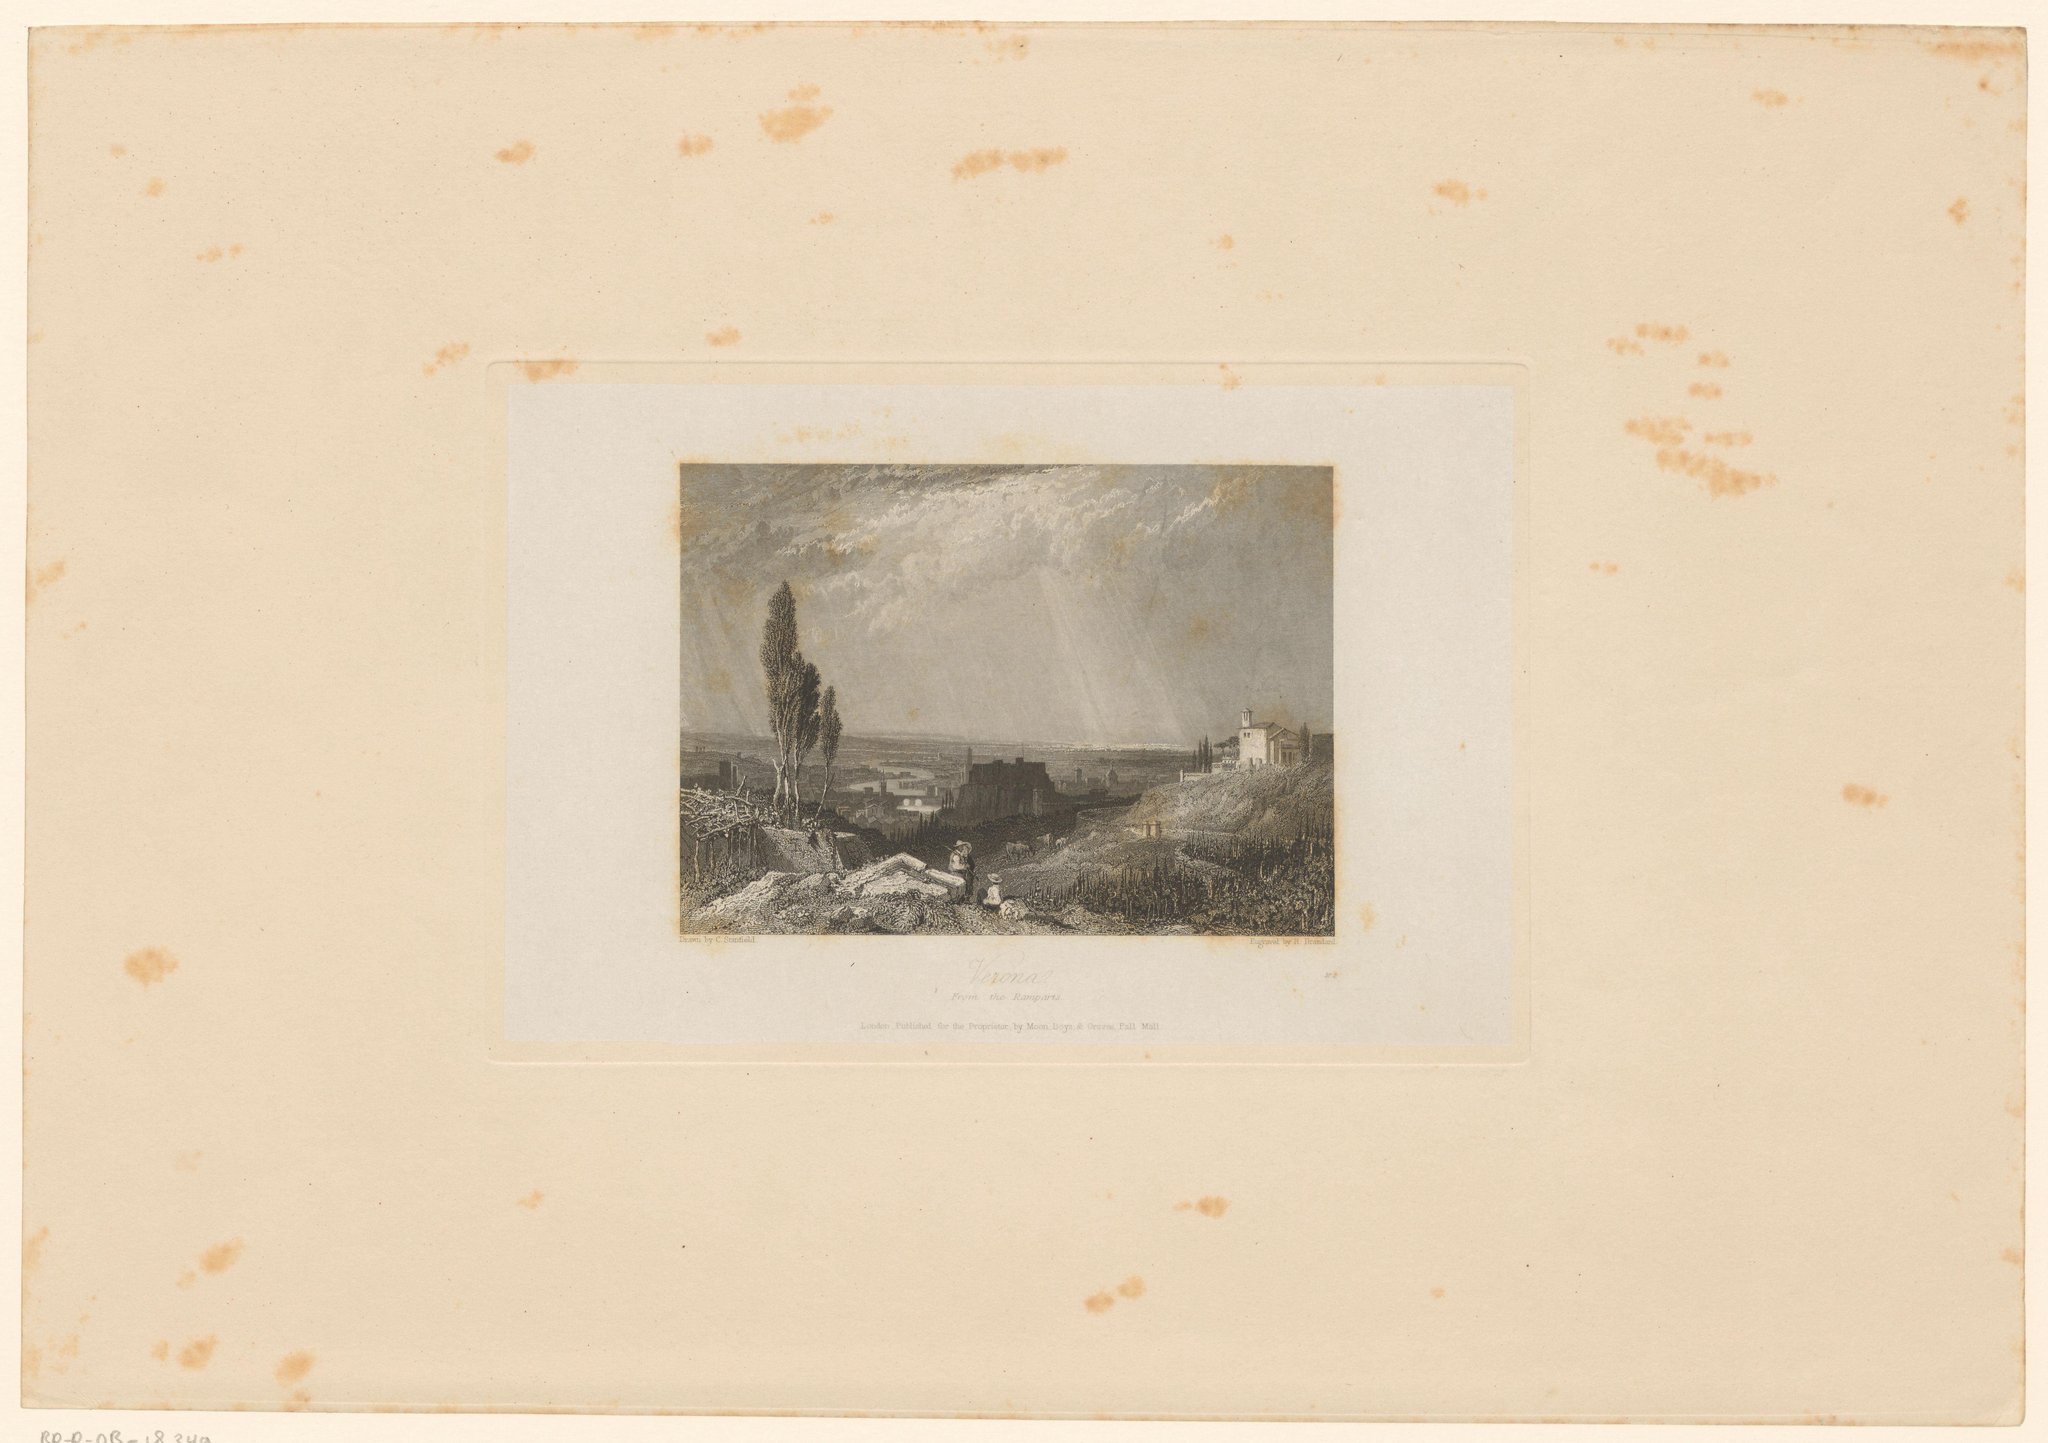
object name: print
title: Gezicht op Verona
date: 1832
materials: paper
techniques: engraving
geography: england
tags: city-view, and landscape with man-made constructions, low hill country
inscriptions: collector's mark: Lugt 2228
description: Huidige staat van prent mogelijk gebruikt in: Heath's Picturesque Annual. Travelling sketches in the north of Italy, the Tyrol and on the Rhine (...). Londen: Longman et al., 1832.